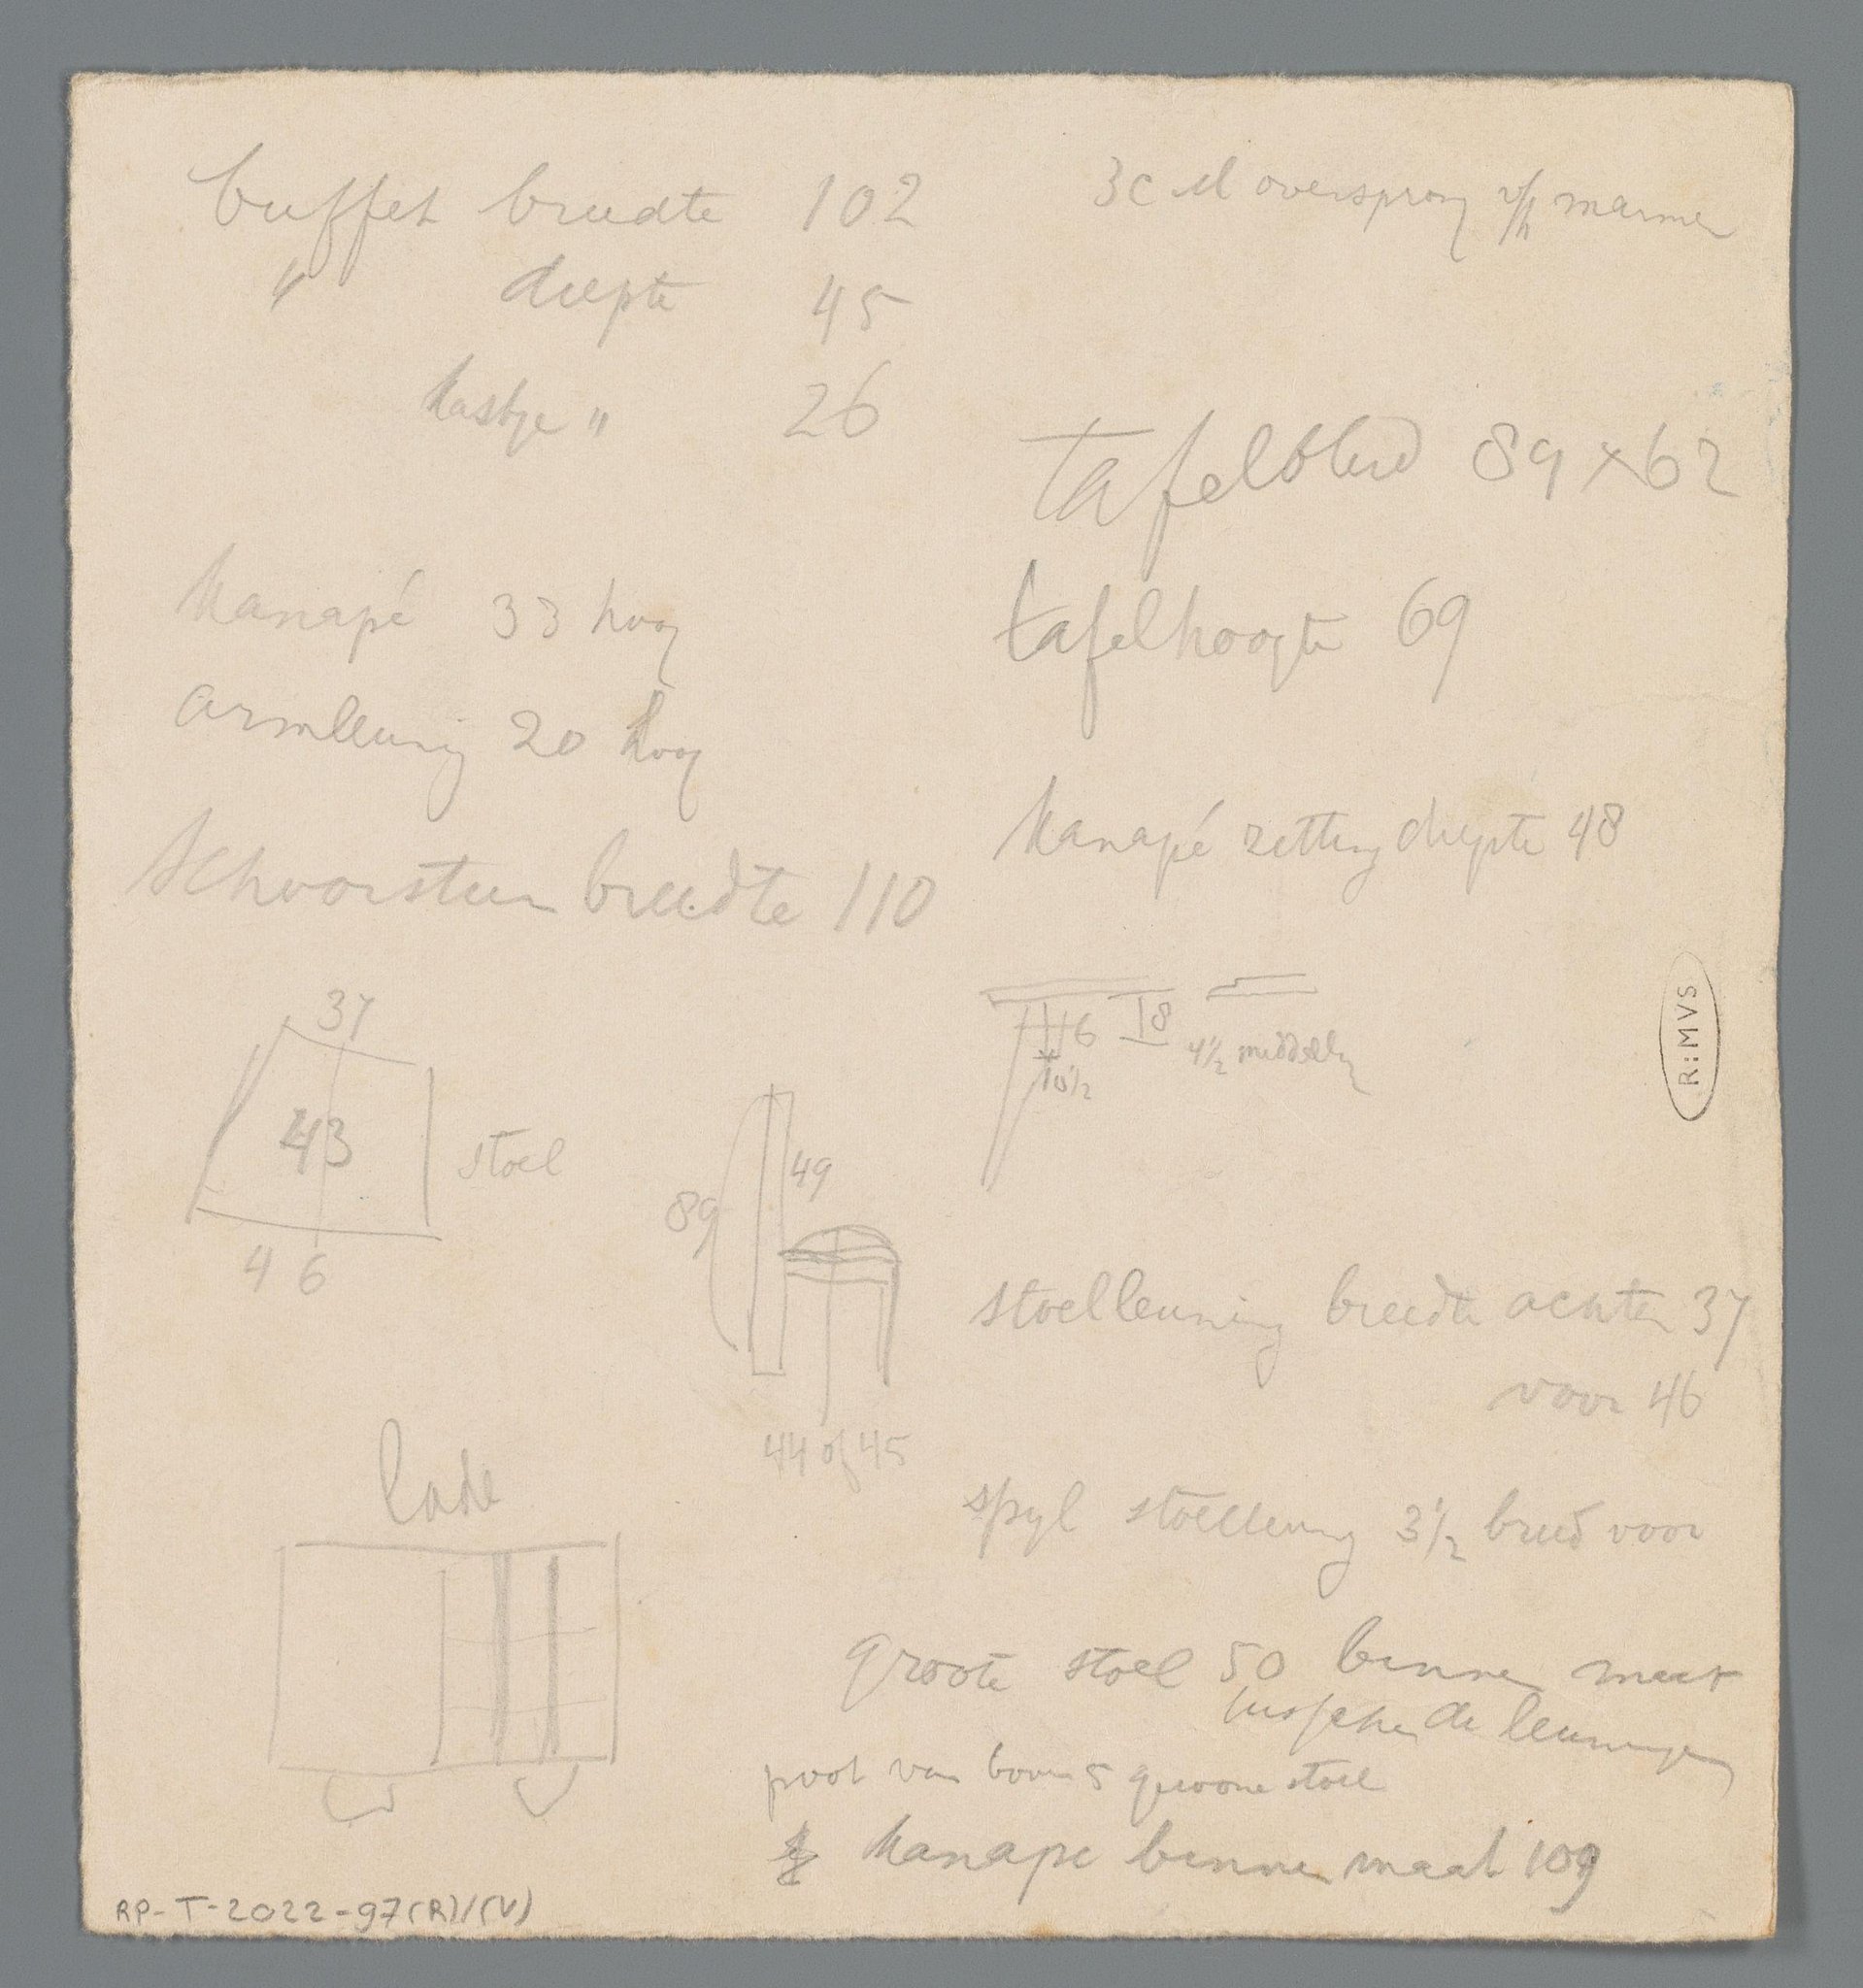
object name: document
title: Aantekeningen en schetsen voor meubels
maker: gust van de wall perné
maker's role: draughtsman, painter, print maker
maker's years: 1877-1911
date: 1887-1911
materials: paper, pencil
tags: furniture for storage, table, chair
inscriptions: collector's mark: Lugt 2228